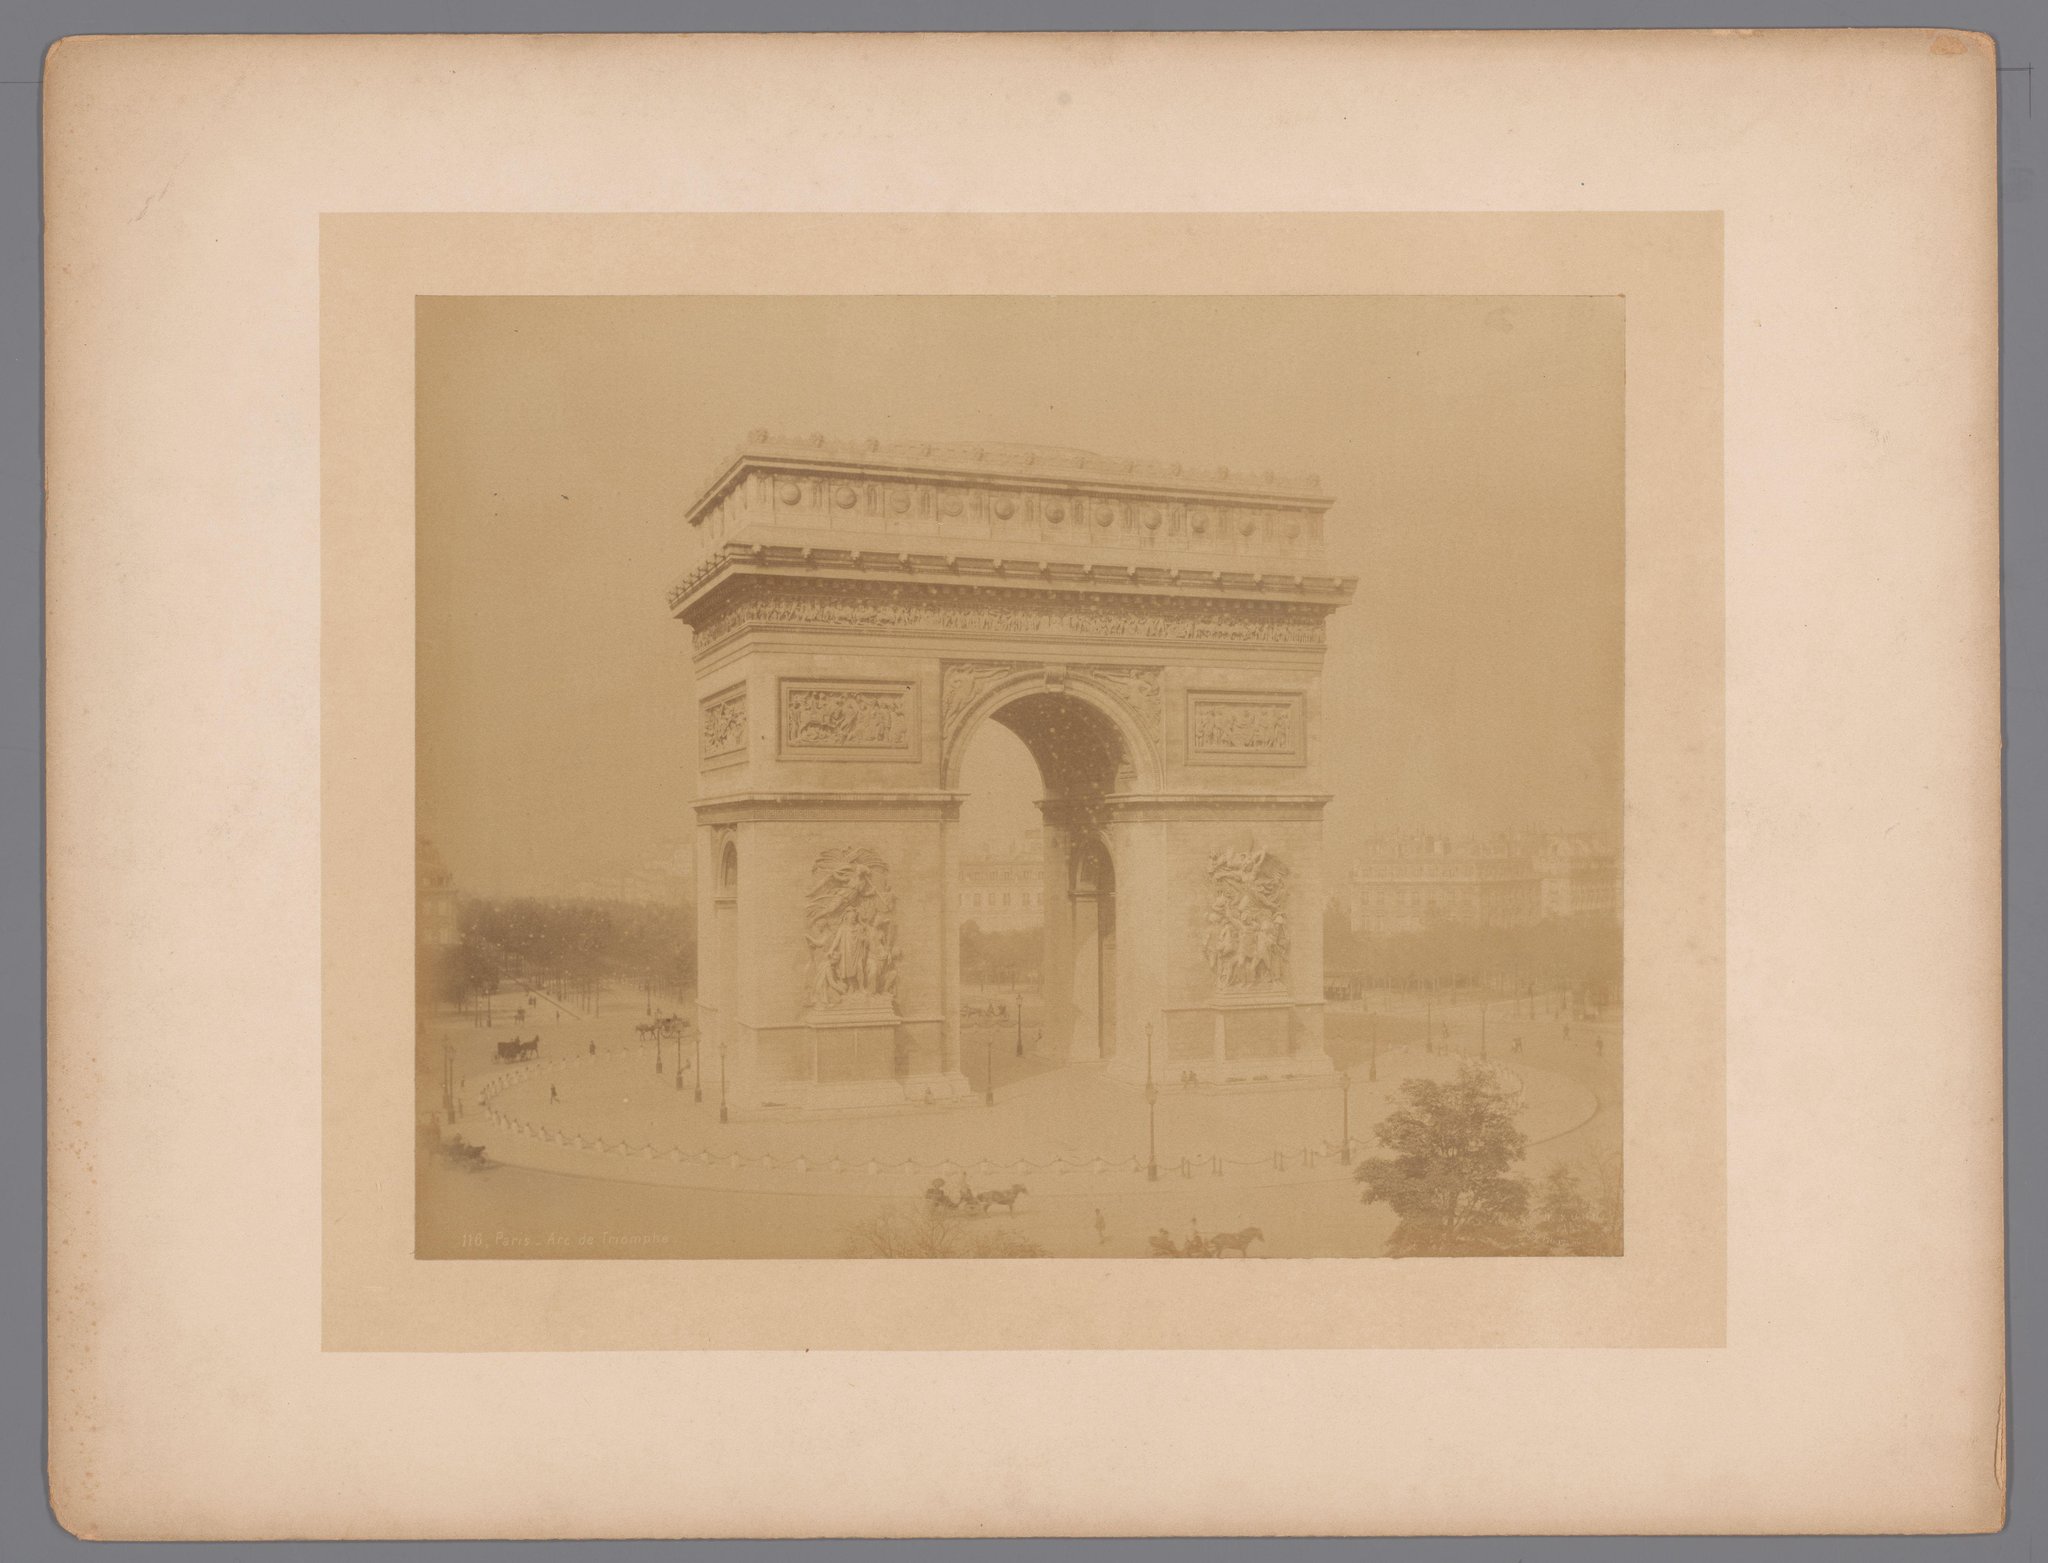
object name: photograph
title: Arc de Triomphe, Parijs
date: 1885-1910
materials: cardboard, paper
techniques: albumen print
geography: paris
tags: arc de triomphe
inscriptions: check stamp: ‘Photographic Company//J. Kühn//Paris//220 170174 Rue de Rivoli’, inscription: ‘116, Paris - Arc de Triomphe’, number: ‘6.’